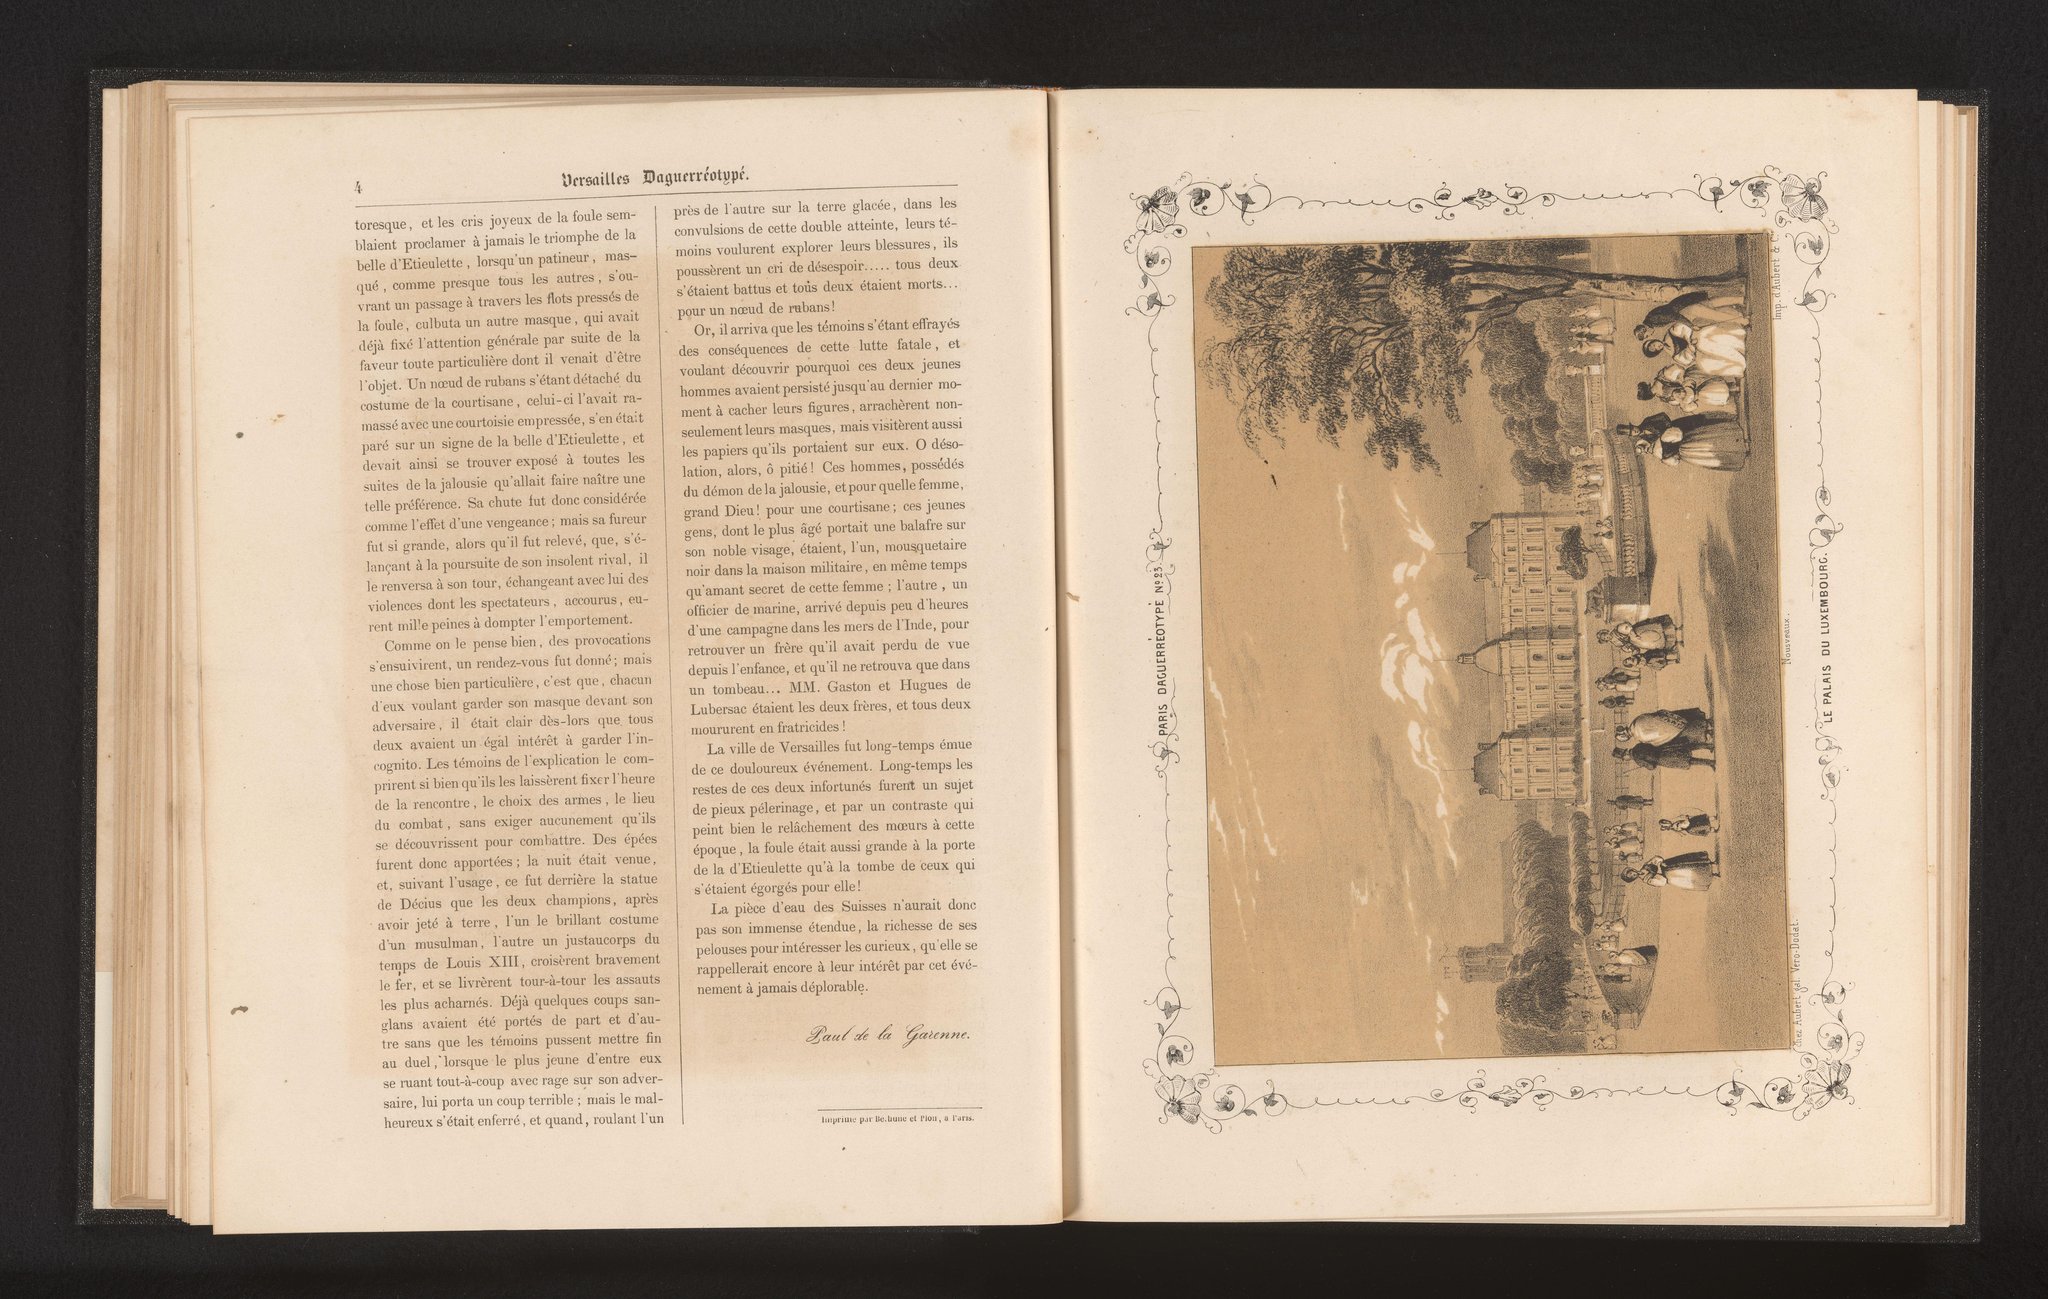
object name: print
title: Gezicht op het Palais du Luxembourg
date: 1839-1840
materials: paper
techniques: tone lithography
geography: paris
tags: palace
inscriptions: inscription: ‘PARIS DAGUERRÉOTYPÉ No. 23.’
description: Prent op eenennegentigste ongenummerde pagina.